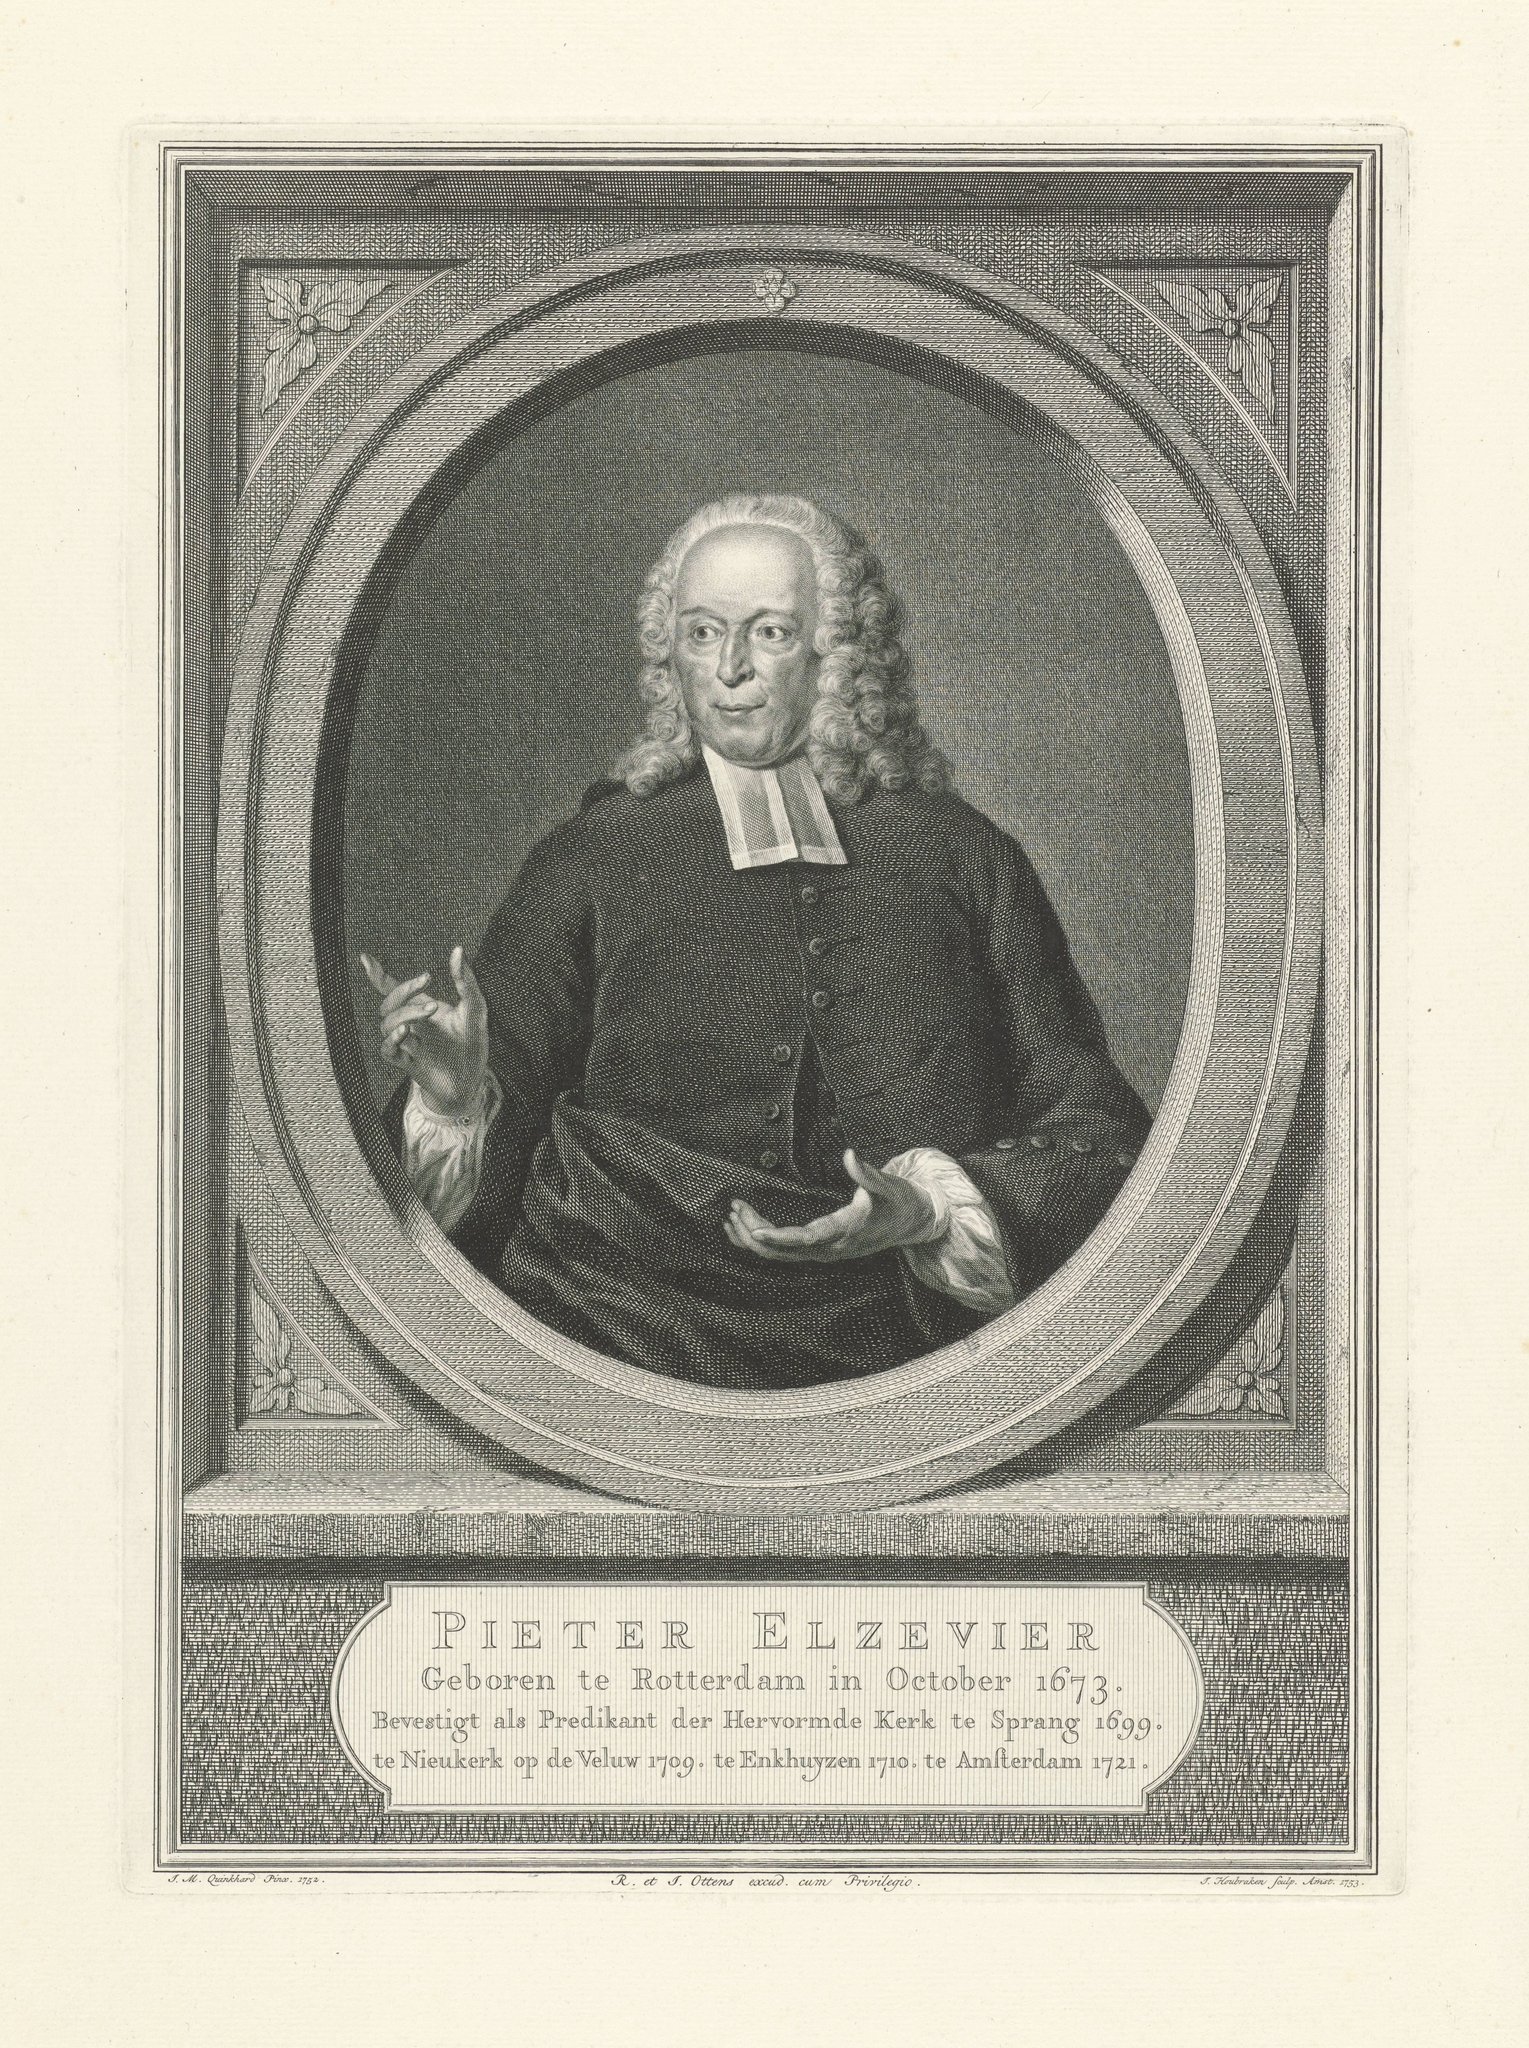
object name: print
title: Portret van Pieter Elzevier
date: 1753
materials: paper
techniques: engraving, etching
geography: amsterdam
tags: predikant, pieter elzevier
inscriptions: collector's mark: Lugt 2228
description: Portret ten halven lijve van Adriaan Johannes Elzevier in een ovaal. Onder het portret een plint waarop een cartouche met zijn naam en gegevens in vier regels in het Nederlands.